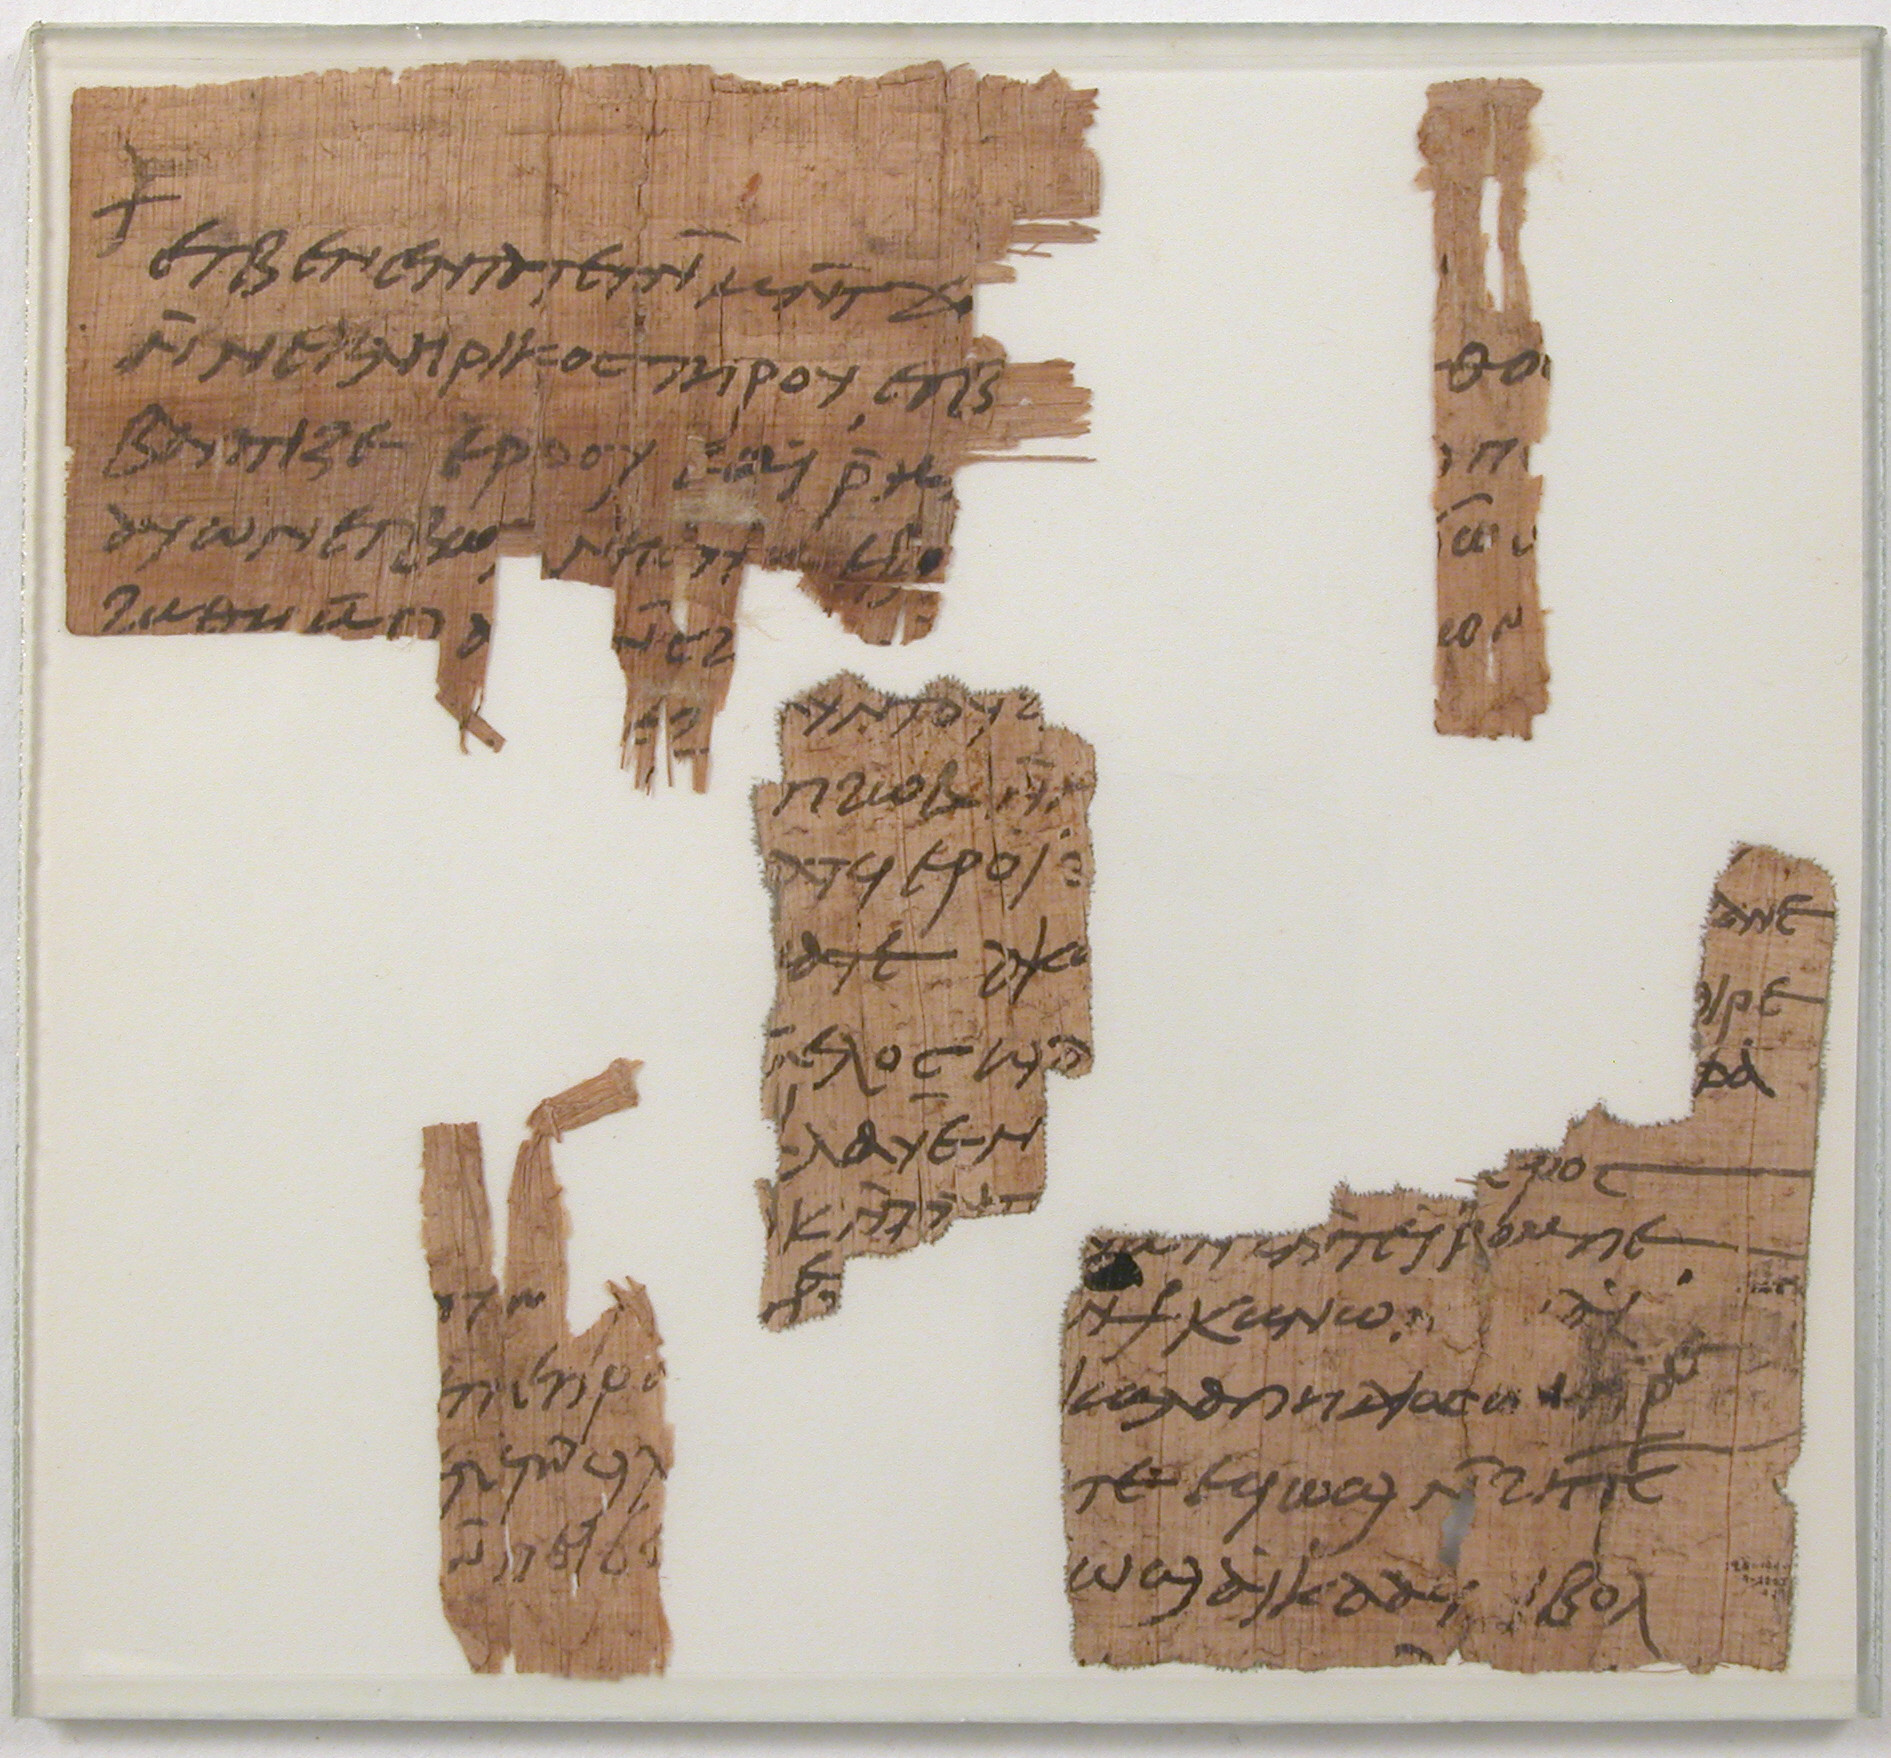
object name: fragment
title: Papyrus Fragments of a Letter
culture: coptic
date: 601-700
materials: ink, papyrus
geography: egypt